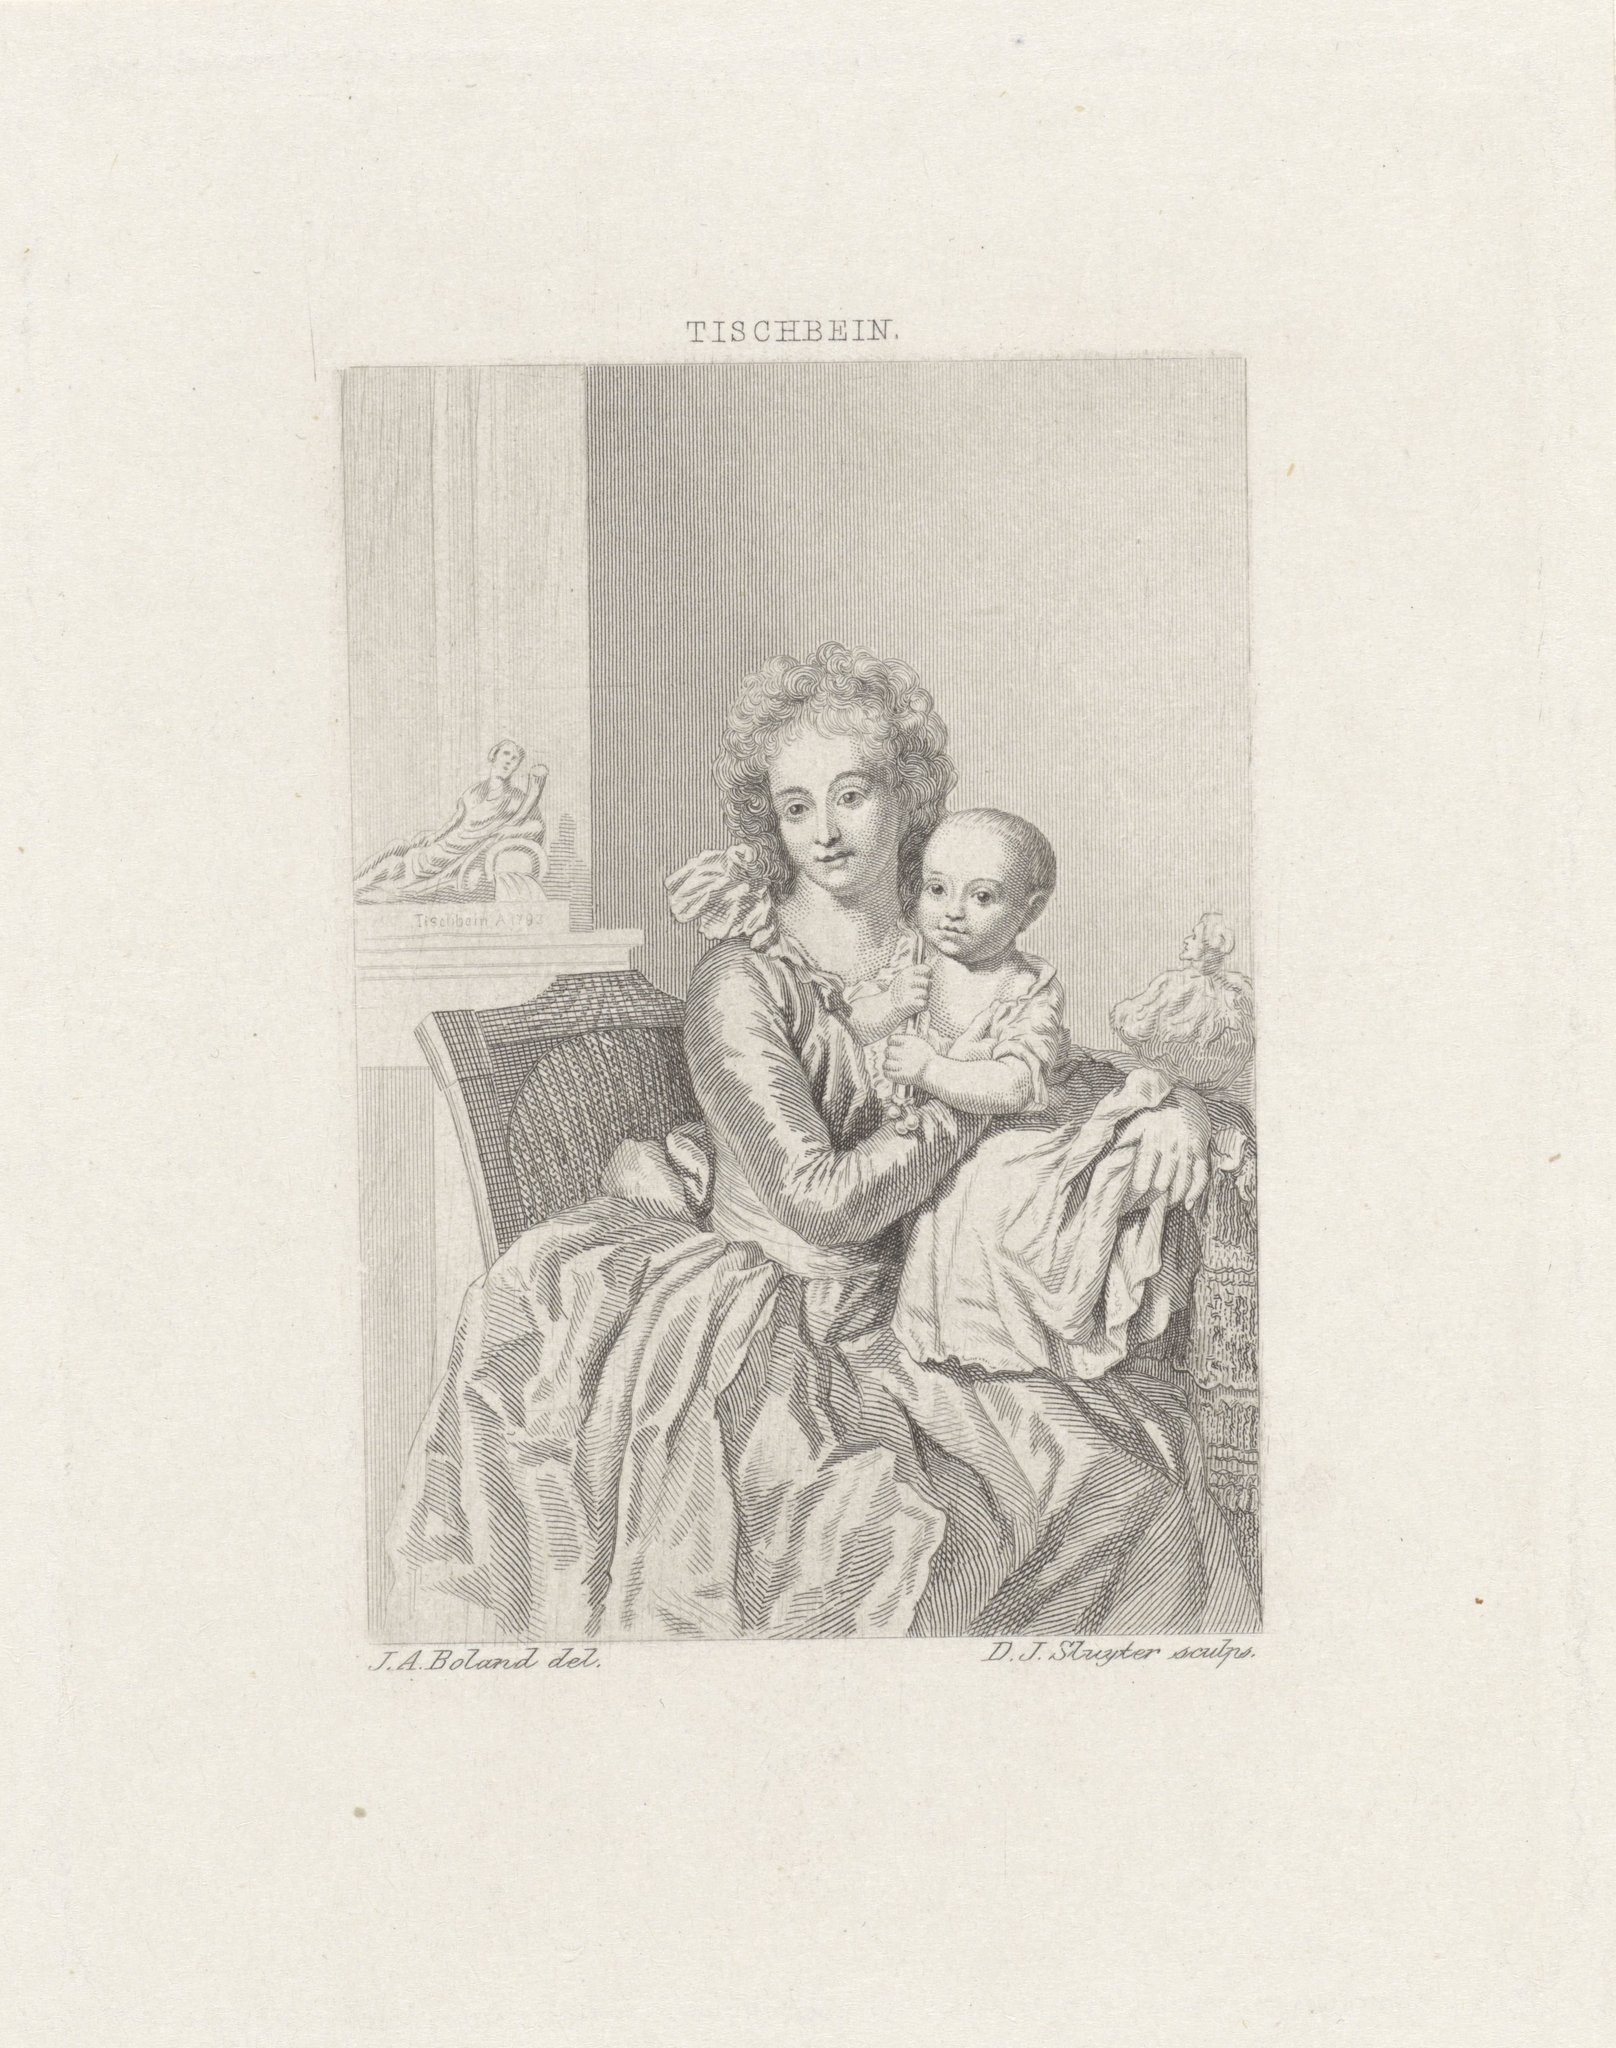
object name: print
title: Moeder met kind op schoot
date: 1864-1886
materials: paper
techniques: engraving, etching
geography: amsterdam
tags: mother and baby or young child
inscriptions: collector's mark: Lugt 2228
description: Voor een schouw zit een jonge vrouw in rijke kledij met een dreumes op schoot.